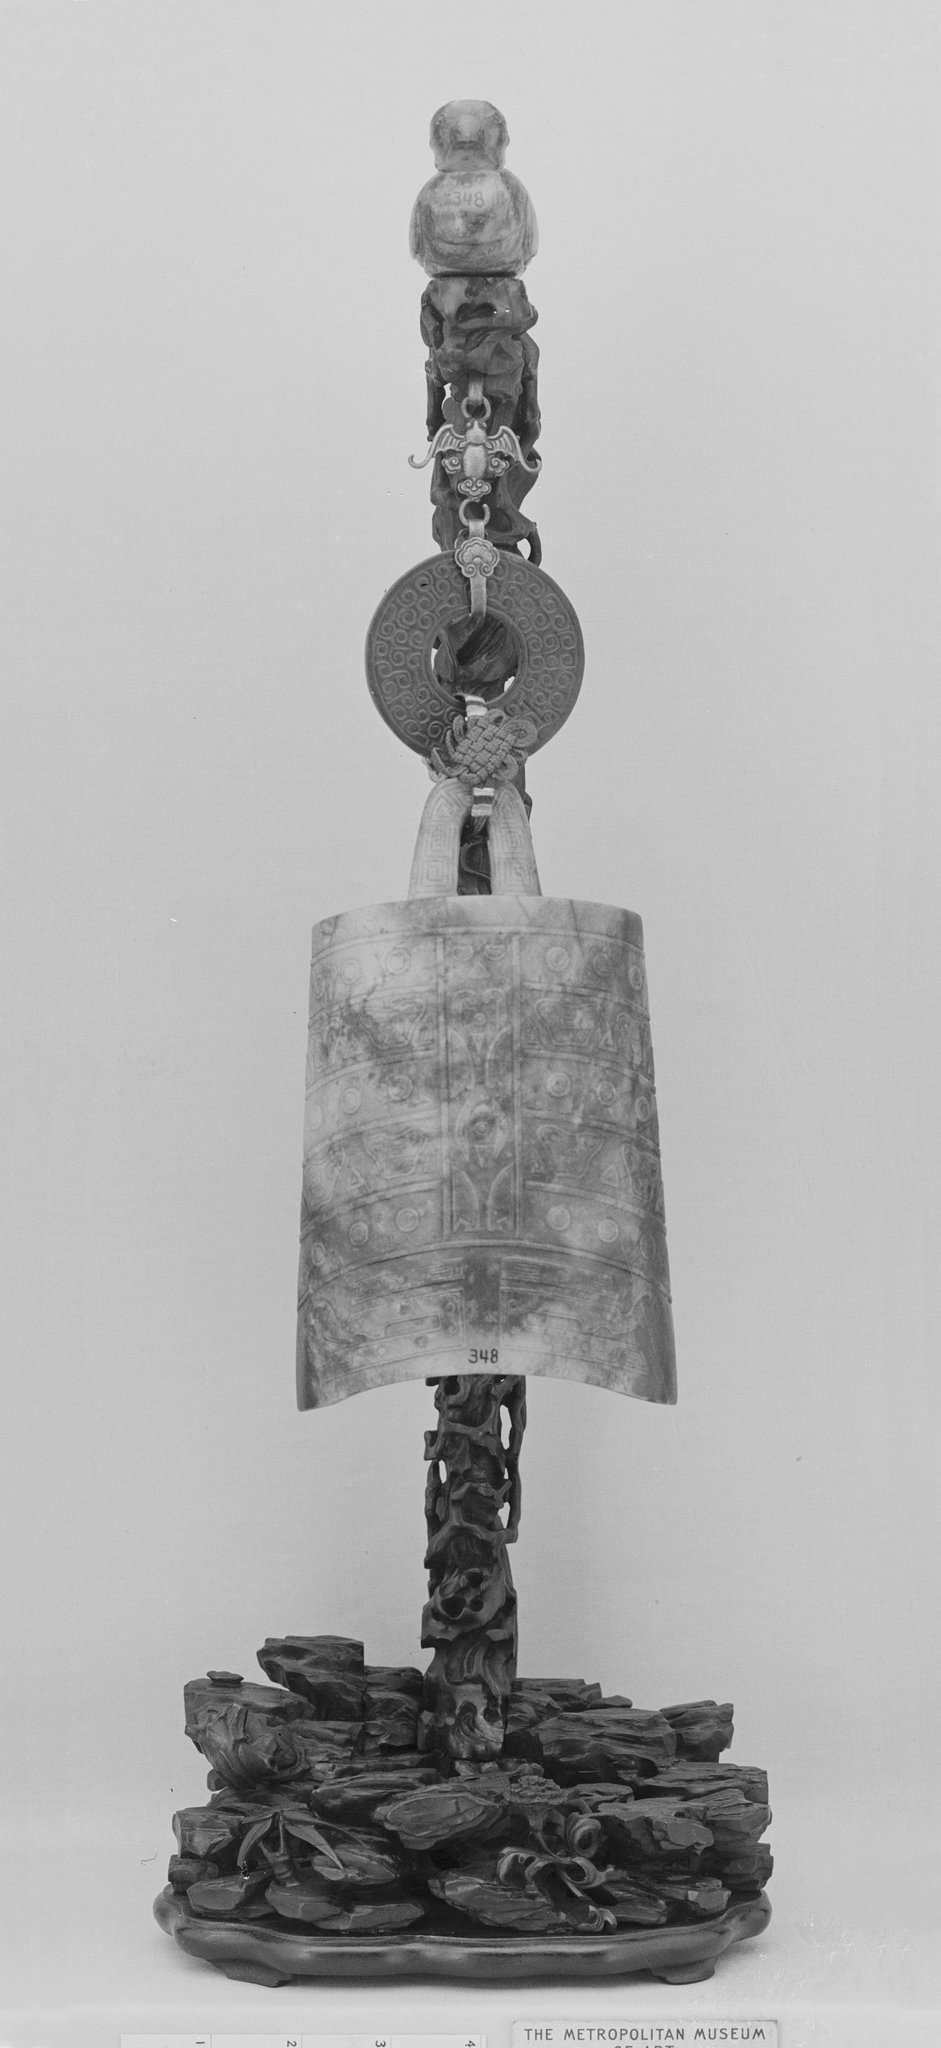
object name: finial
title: Staff Finial with Bell Ring and Bird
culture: chinese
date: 206 BCE-220 CE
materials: jade